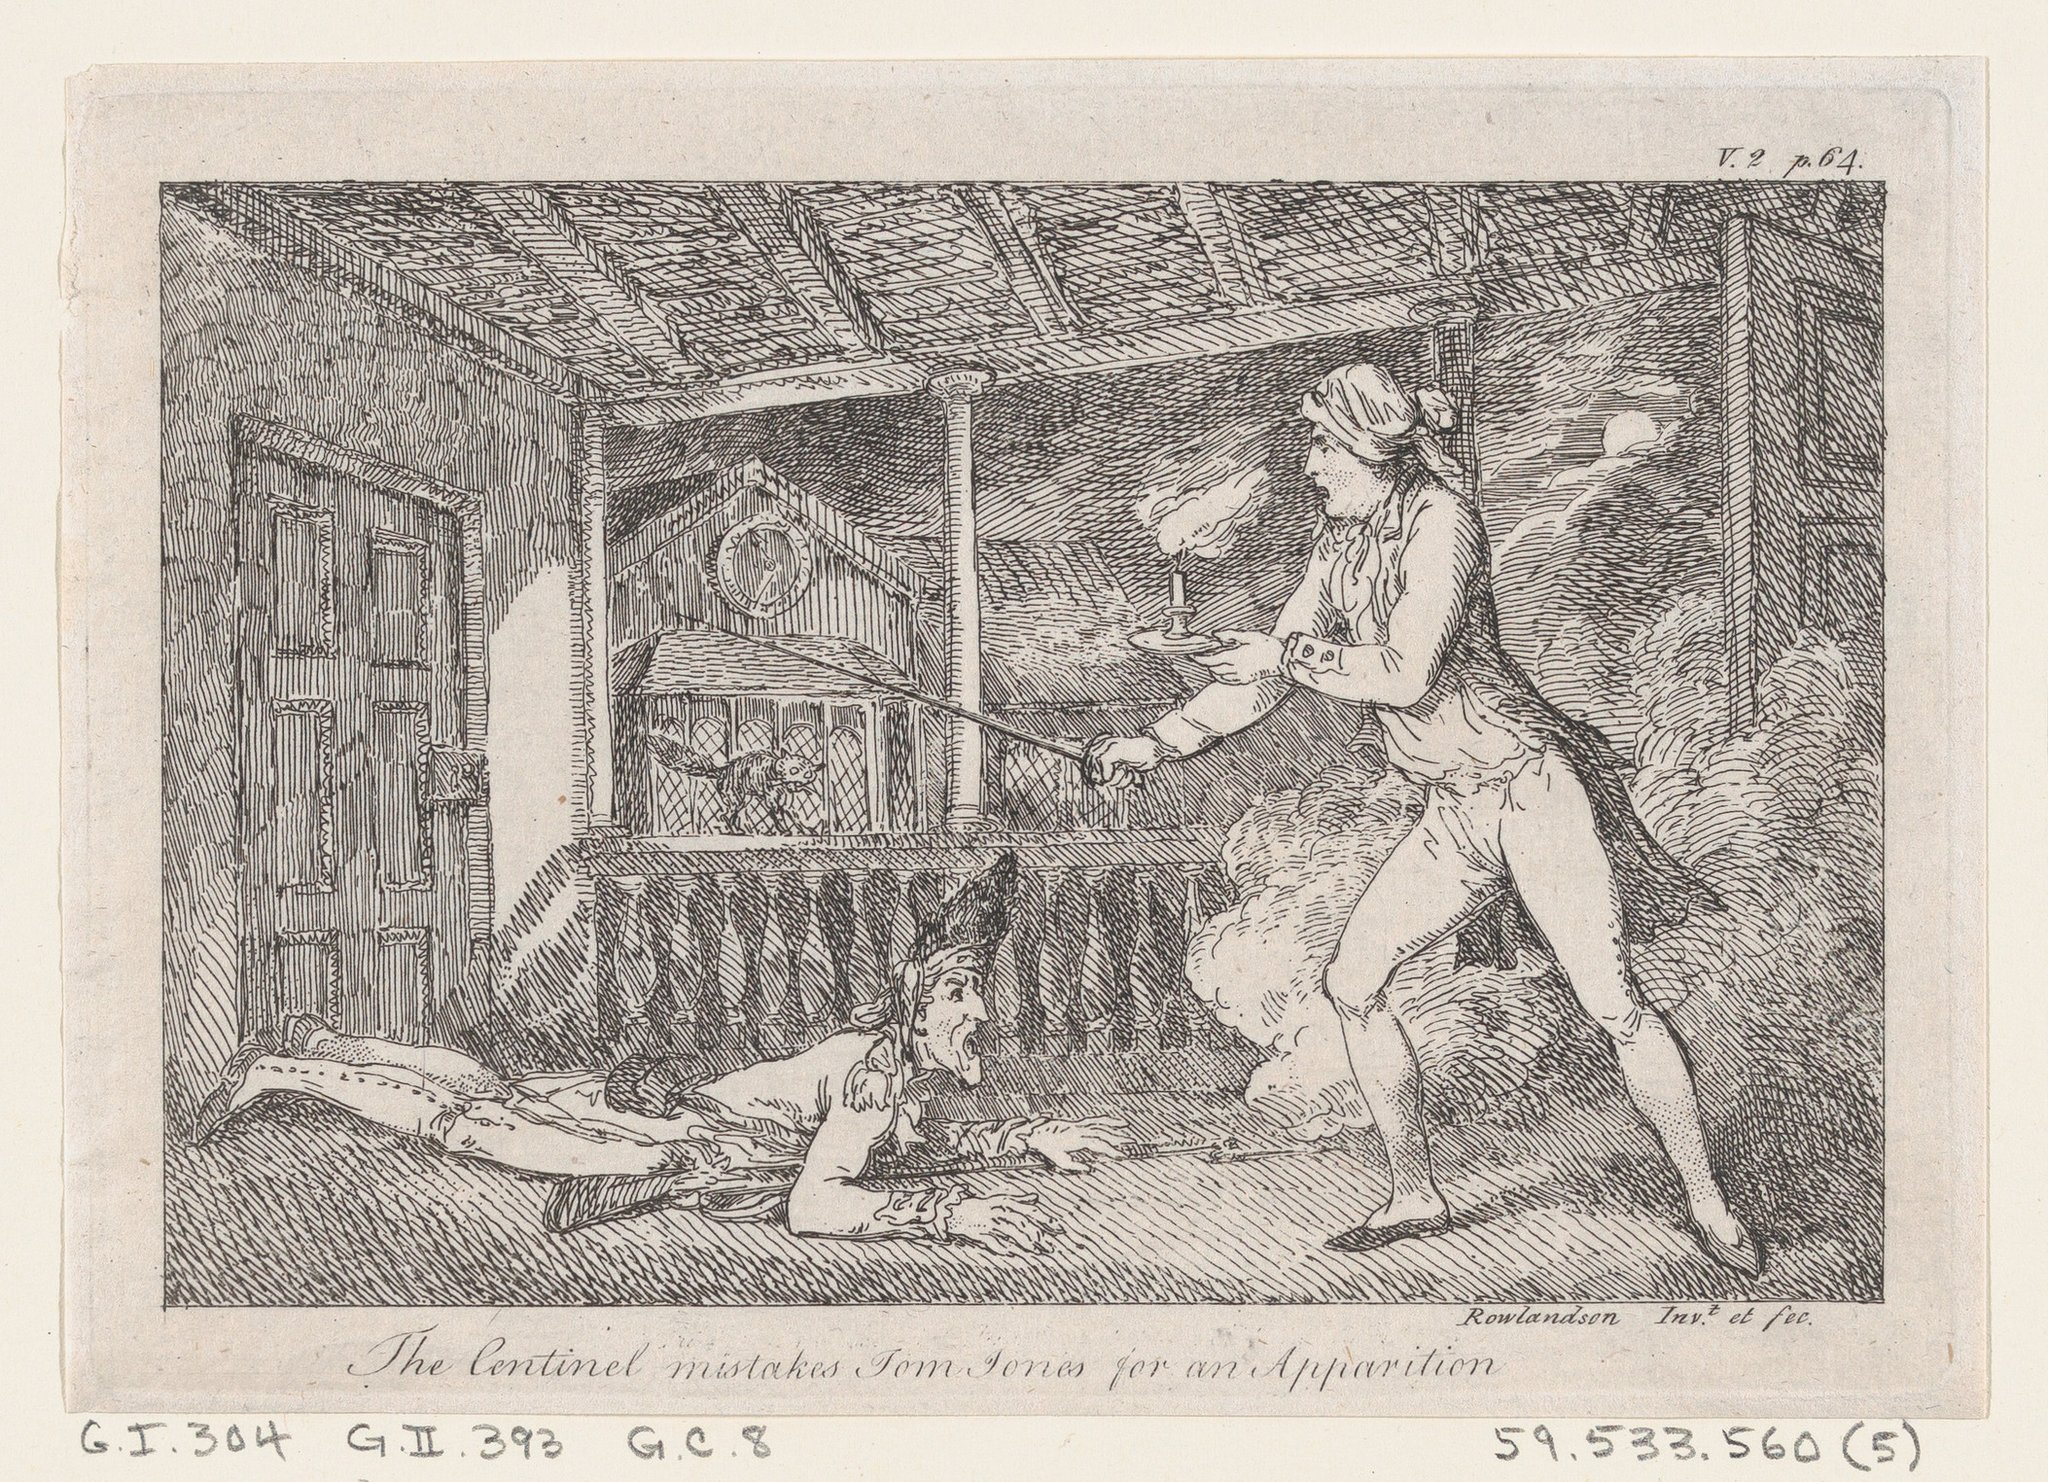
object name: print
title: The Sentinel Mistakes Tom Jones for an Apparition, from "The History of Tom Jones, a Foundling"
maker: thomas rowlandson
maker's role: artist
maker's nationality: british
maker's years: 1757-1827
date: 1792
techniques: etching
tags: satire,men